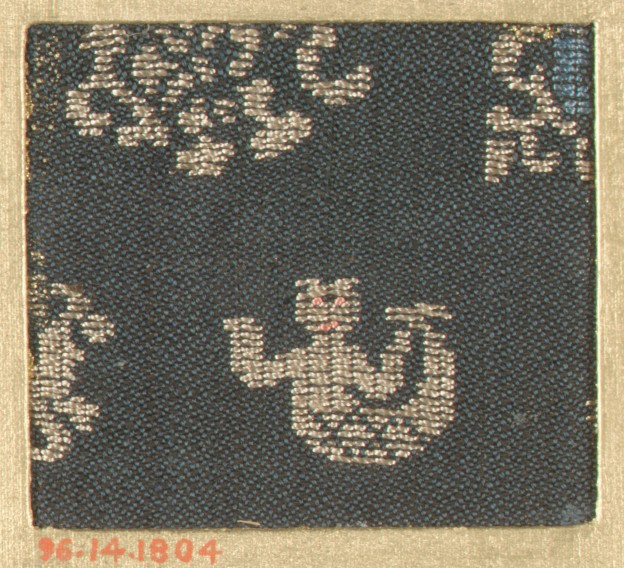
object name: piece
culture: japanese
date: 1701-1900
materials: silk